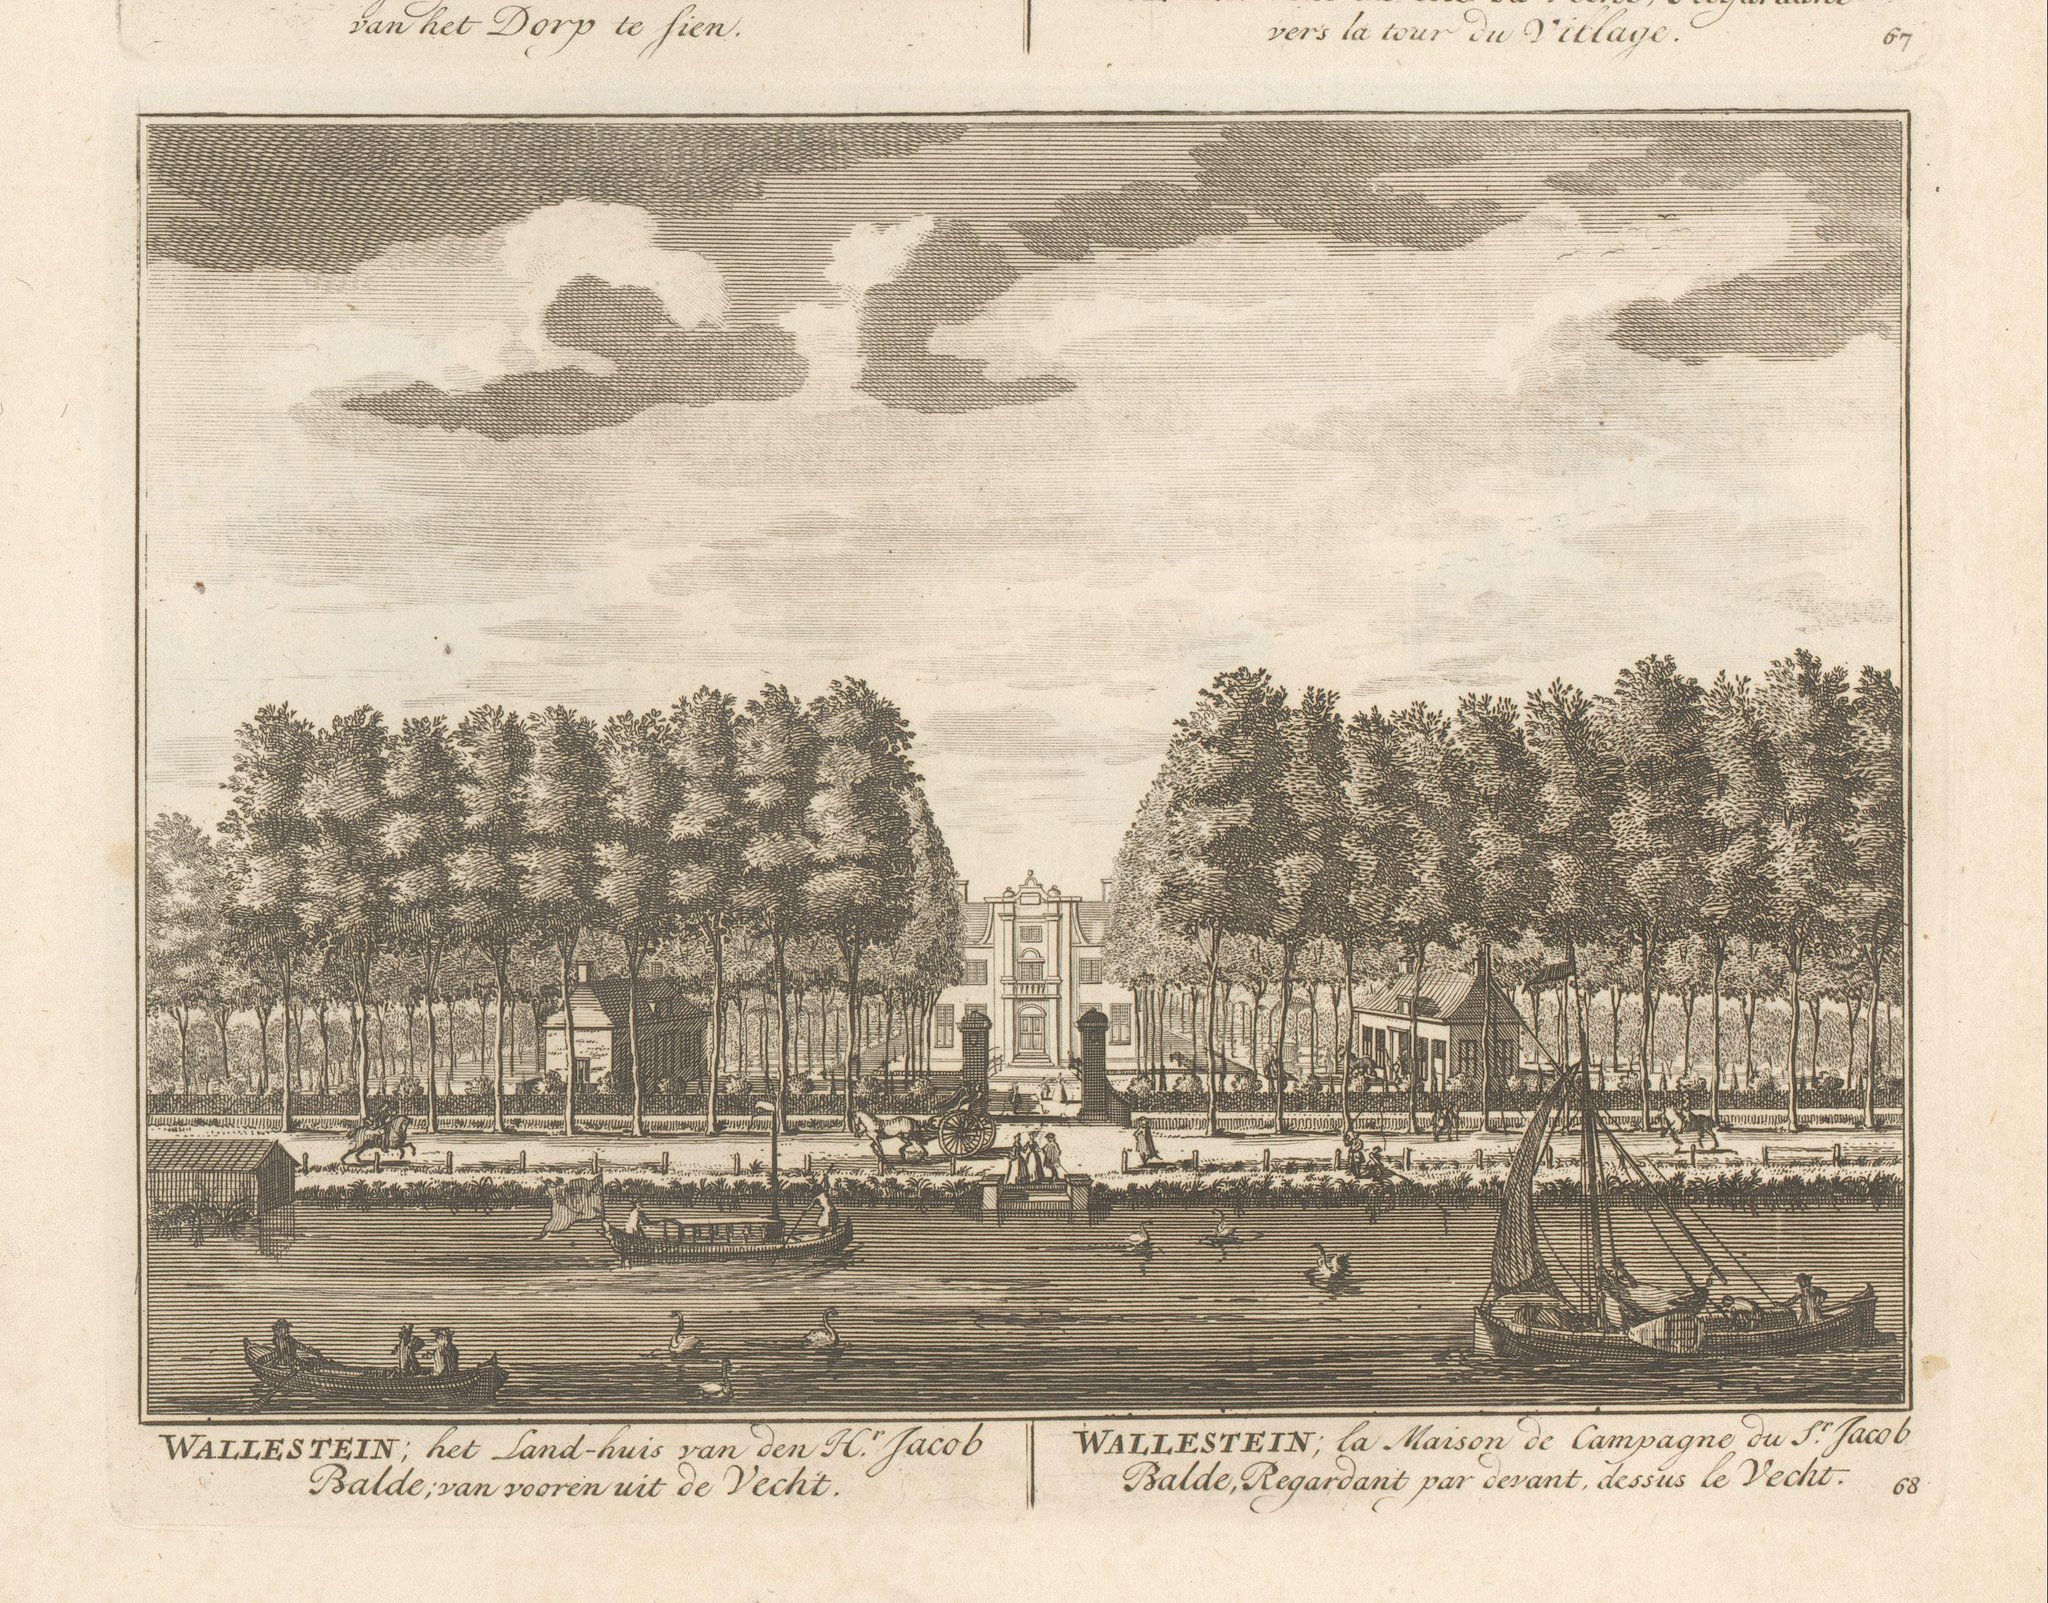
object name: album leaf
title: Gezicht op de buitenplaats Wallestein aan de Vecht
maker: daniël stopendaal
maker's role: print maker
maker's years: 1672-1726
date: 1790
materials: paper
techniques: engraving, etching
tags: river (+ landscape with figures, staffage), country-house, vecht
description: Prent gebruikt in: Leth, Andries de. De zegepraalende Vecht, vertoonende verscheidene gesichten van lustplaatsen, heeren huysen en dorpen, beginnende van Uitrecht en met Muyden besluytende (...). Amsterdam: Weduwe Nicolaus Visscher, 1719. Prent ook gebruikt in: Brouërius van Nidek, Matthaeus. De Vechtstroom, van Utrecht tot Muiden (...). Amsterdam: H. Gartman, W. Vermandel en J.W. Smit, 1790.